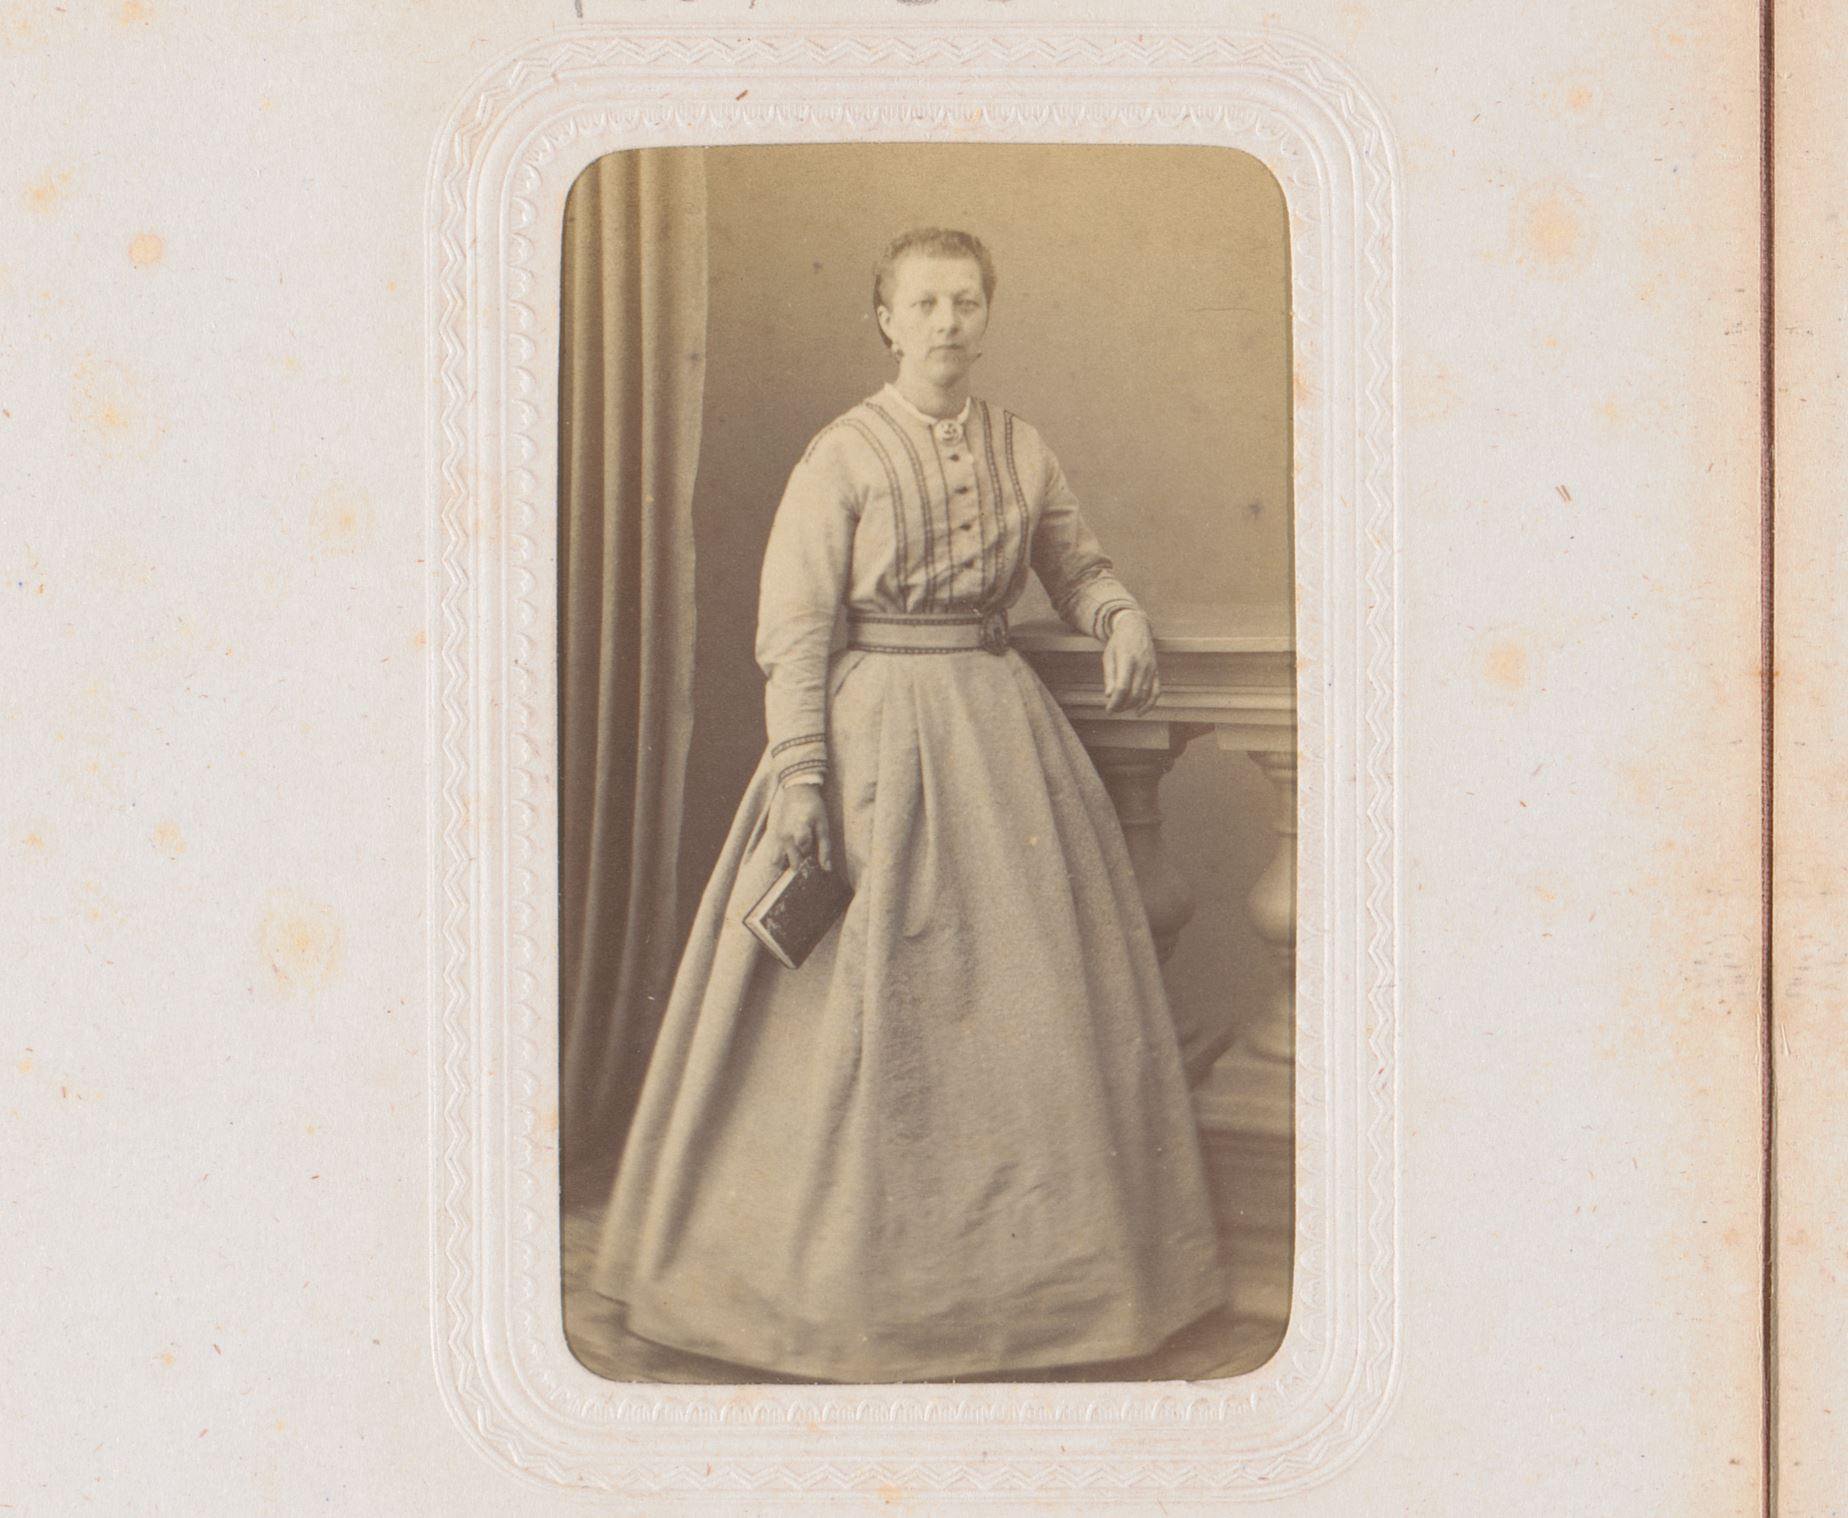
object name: photograph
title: Portret van een staande vrouw met boek in de hand, leunend op een balustrade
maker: kornelis willem schorteldoek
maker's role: boekbinder, fotograaf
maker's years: 1800-1885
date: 1855-1885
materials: cardboard, photographic support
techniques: albumen print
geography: gorinchem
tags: historical persons - bb - woman, balustrade, book, standing figure - aa - female human figure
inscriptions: inscription: ‘SCHORTELDOEK/ PHOTOGRAAF/ GORINCHEM/ Groote Markt’